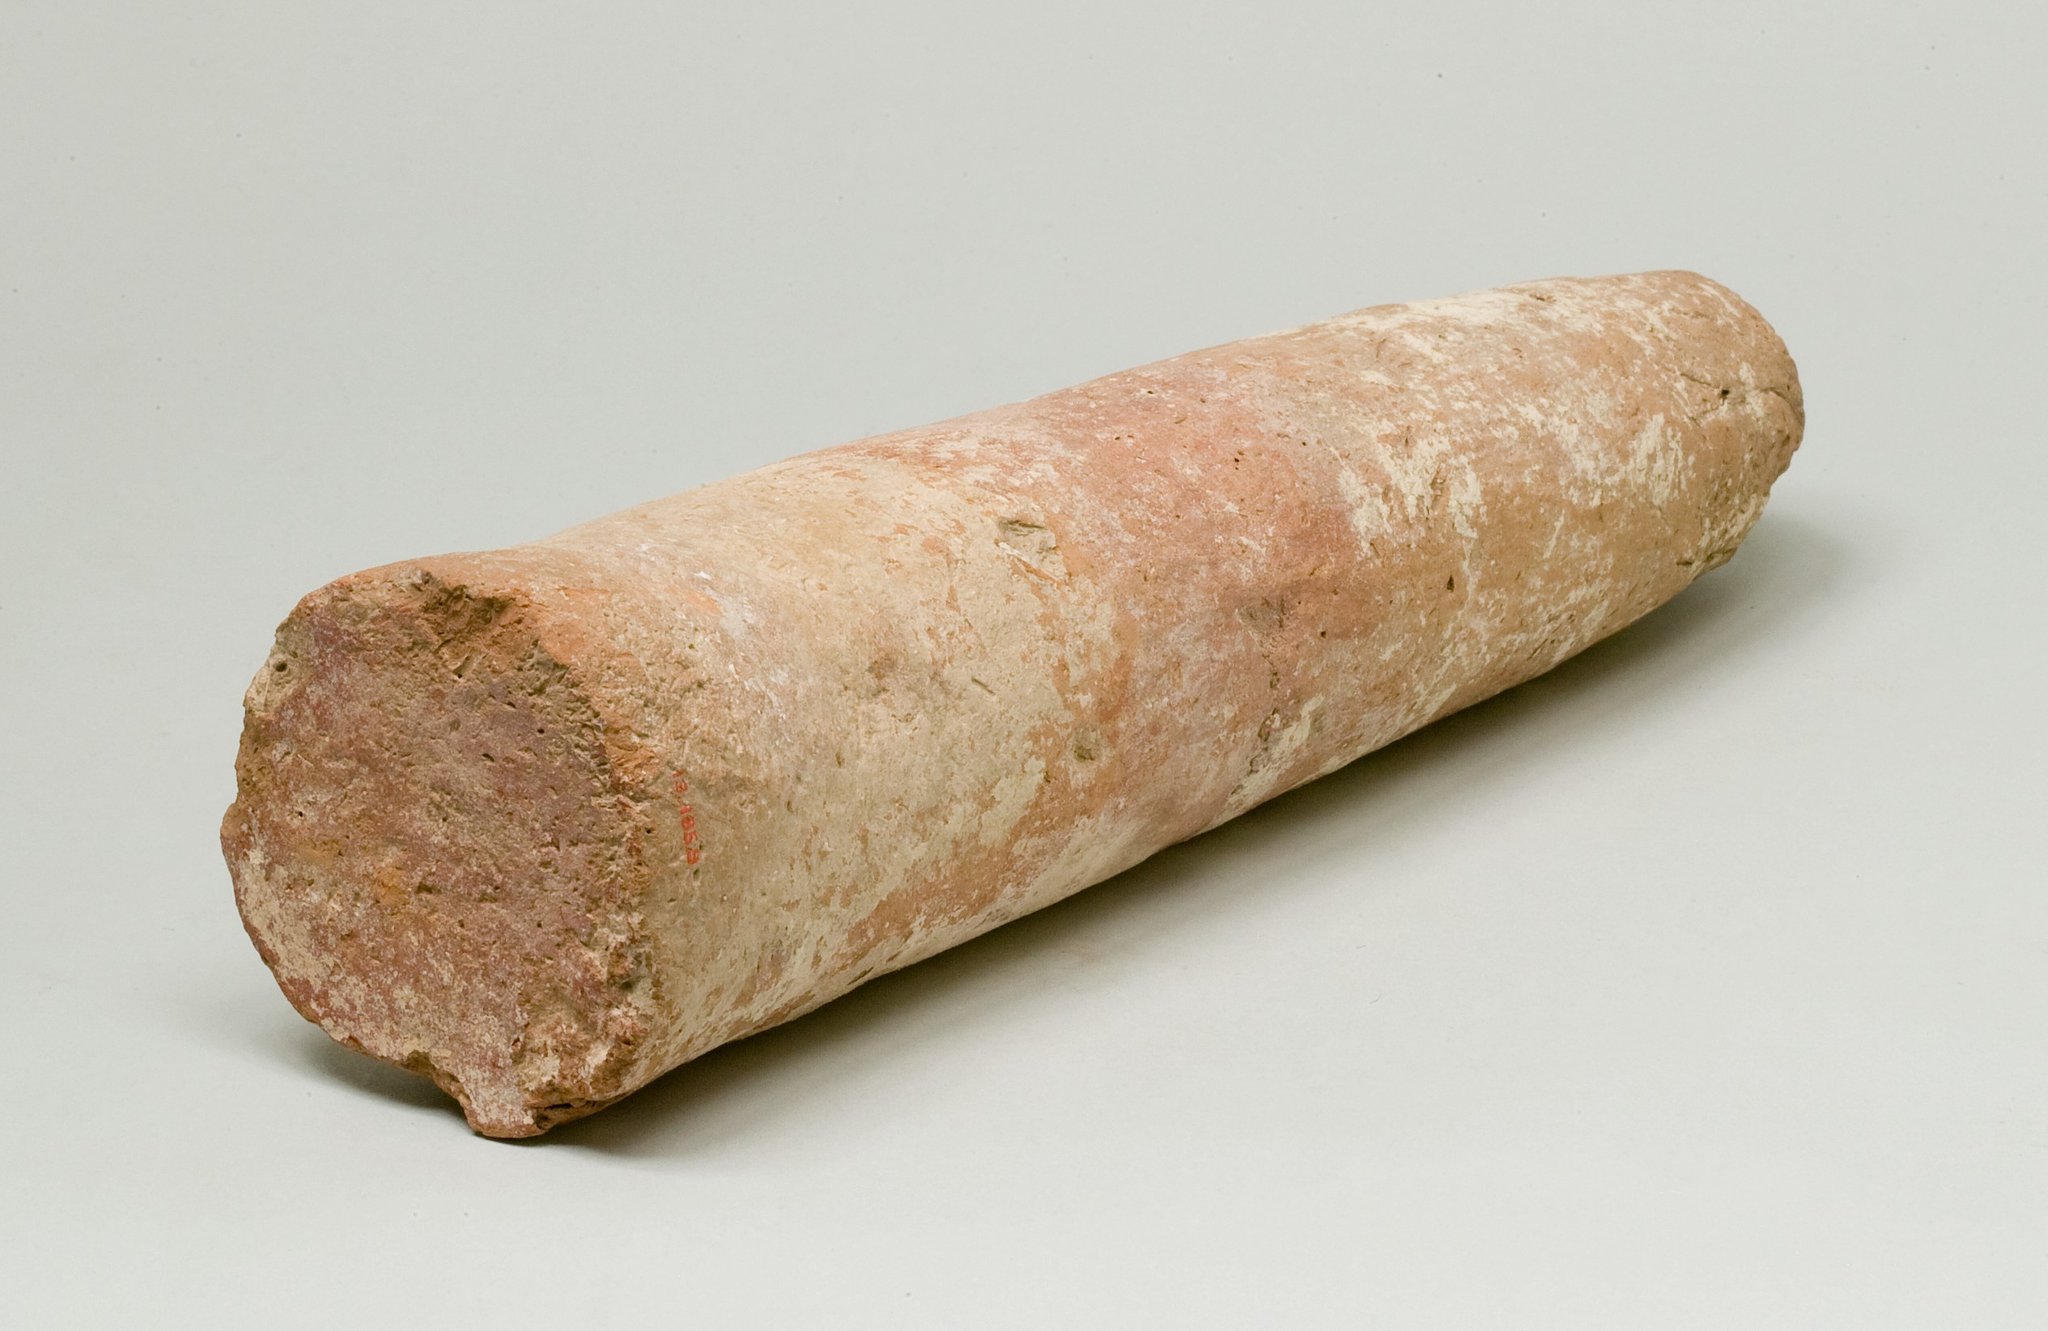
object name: cone, uninscribed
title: Funerary cone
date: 2030-1640 BCE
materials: pottery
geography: egypt